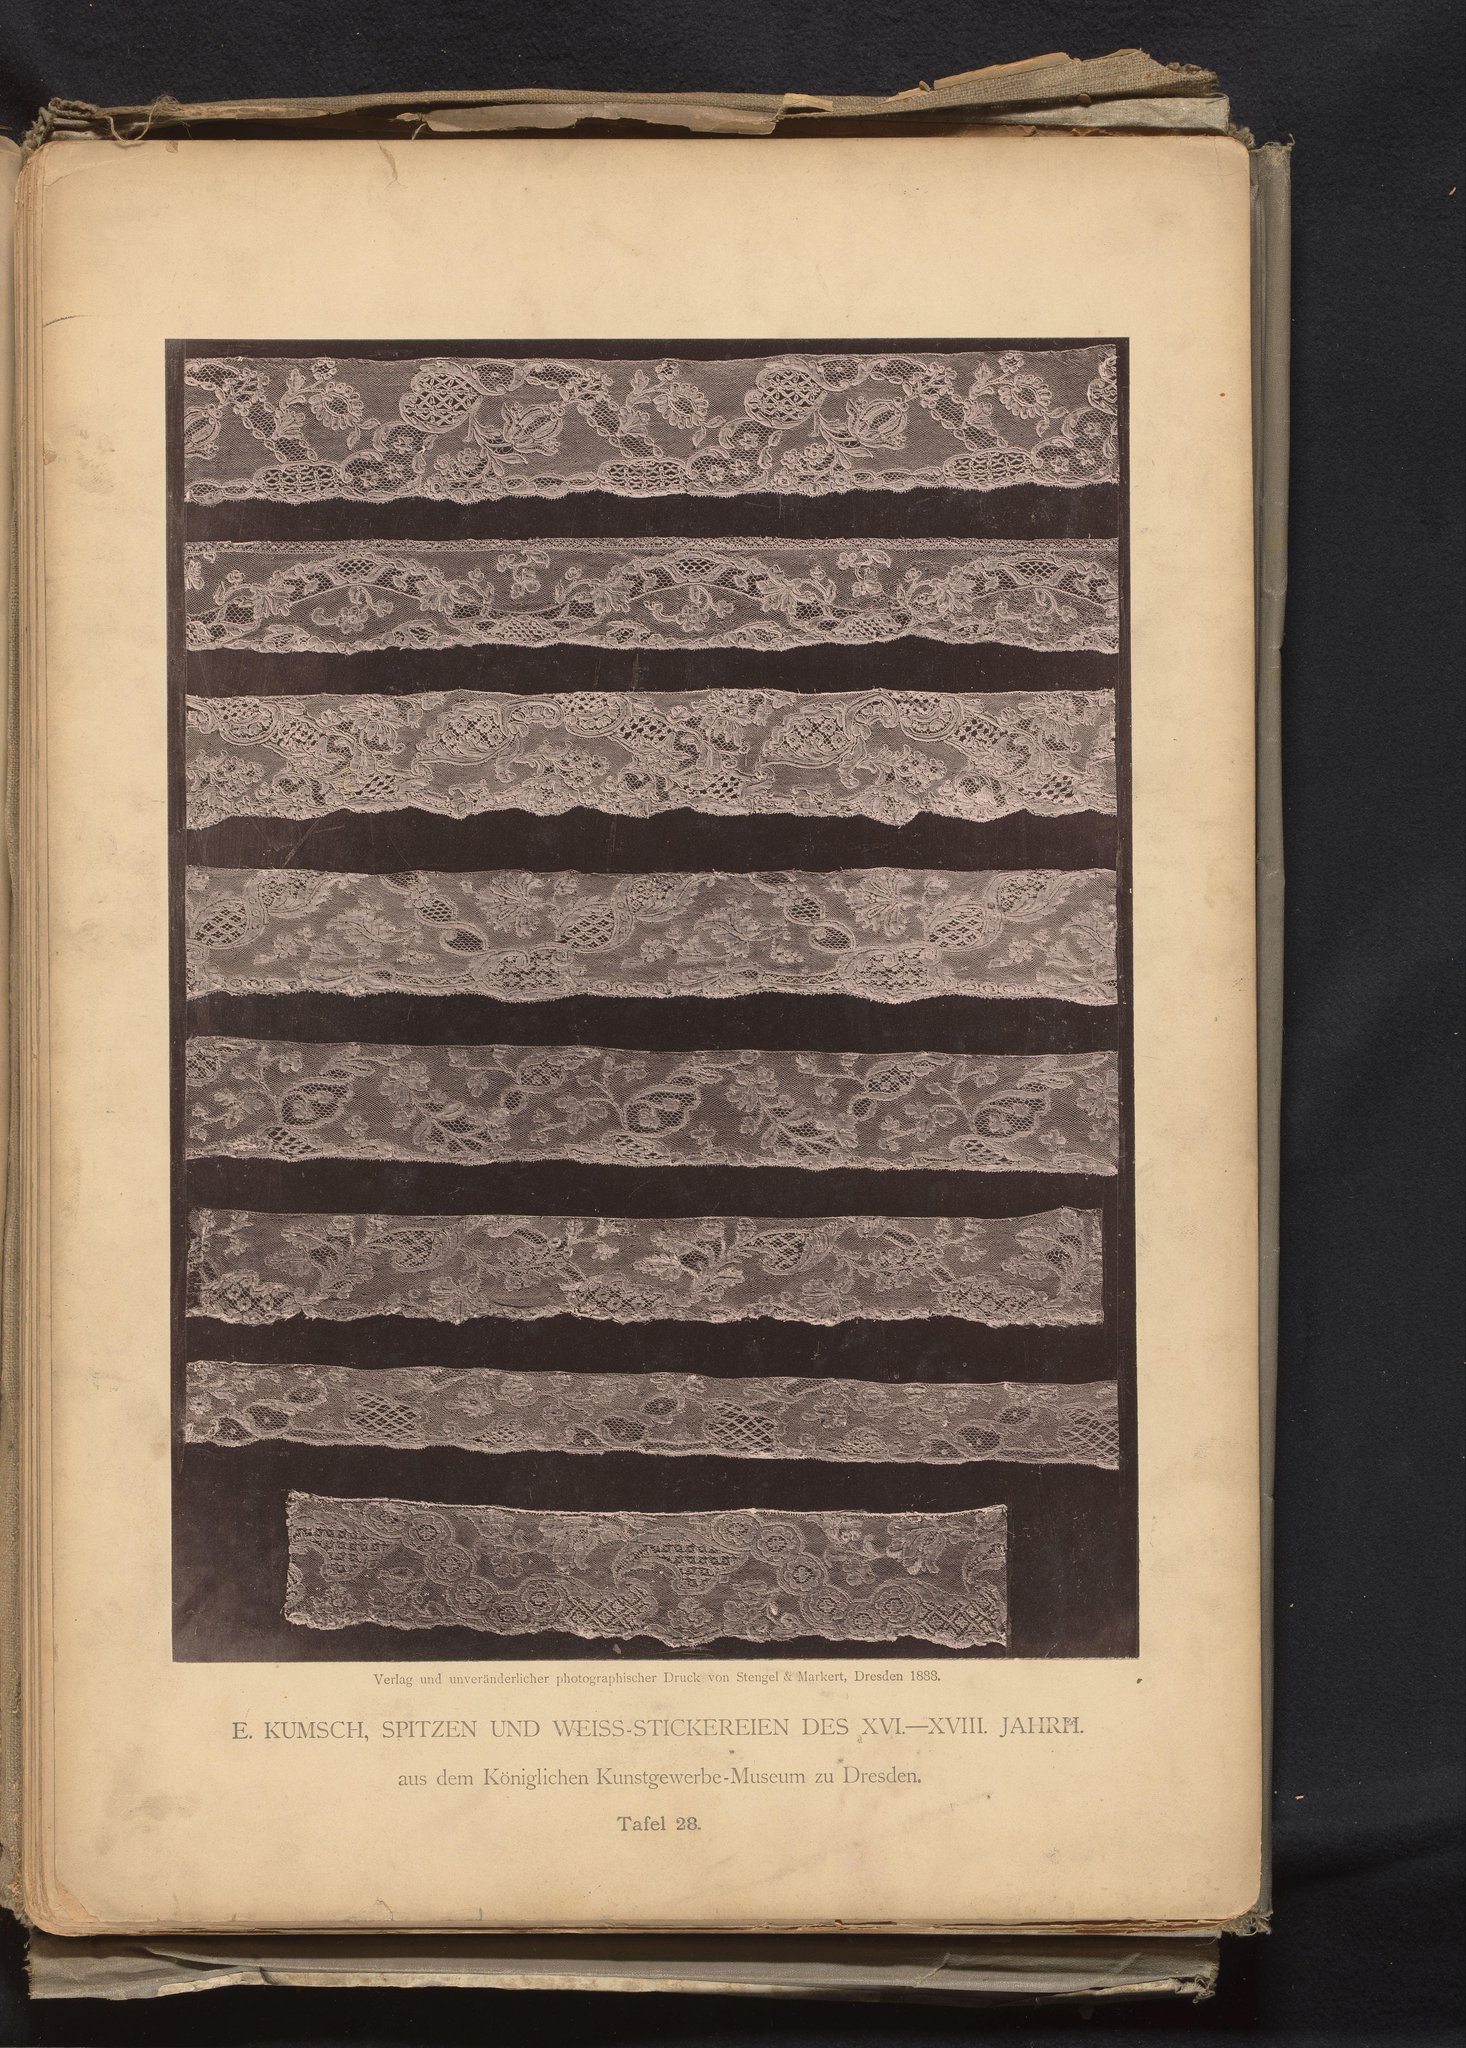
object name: photomechanical print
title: Acht stroken 18de-eeuws kant geproduceerd in Mechelen, uit de collectie van het Kunstgewerbemuseum in Dresden, Duitsland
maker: Anonymous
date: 1888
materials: paper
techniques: photograph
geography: dresden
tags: lace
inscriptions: inscription: ‘E. KUMSCH, SPITZEN UND WEISS-STICKEREIEN DES XVI.-XVIII. JAHRH./ aus dem Königlichen Kunstgewerbe-Museum zu Dresden’, number: ‘Tafel 28.’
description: Deze prent maakt deel uit van een omslag met 49 prenten en een lijst van afbeeldingen.